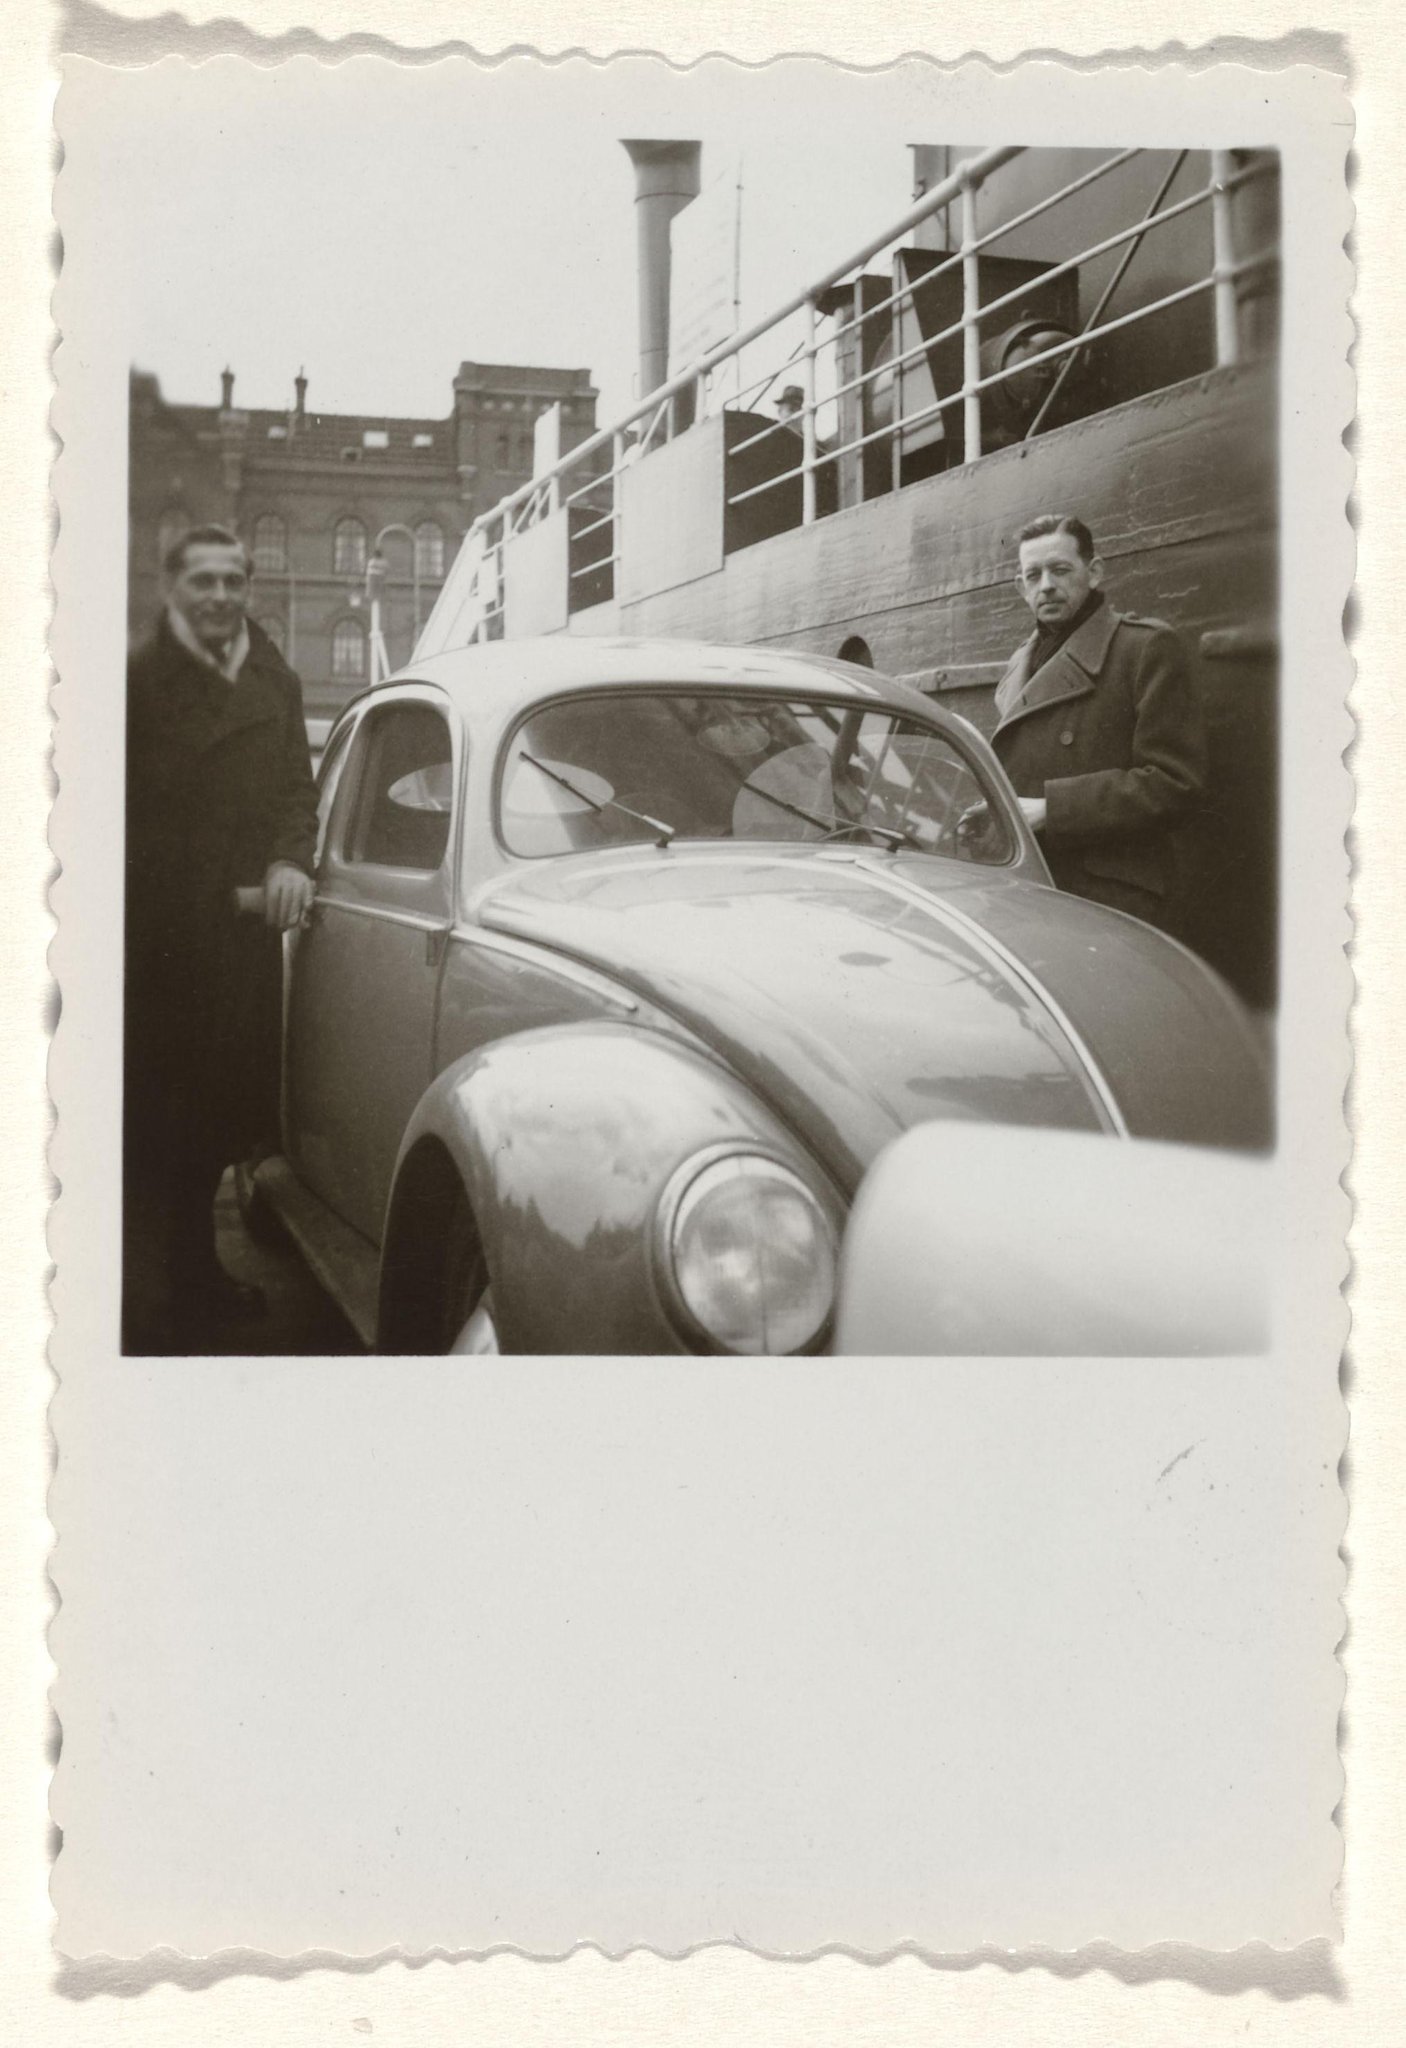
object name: photograph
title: Gideon Elon, de derde echtgenoot van Isabel Wachenheimer, met een onbekende man staande bij een auto, voor een groot schip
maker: Anonymous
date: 1956-1970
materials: photographic support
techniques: gelatin silver print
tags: gideon elon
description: Gideon Elon (links), de derde echtgenoot van Isabel Wachenheimer, met een onbekende man staande bij een auto, voor een groot schip